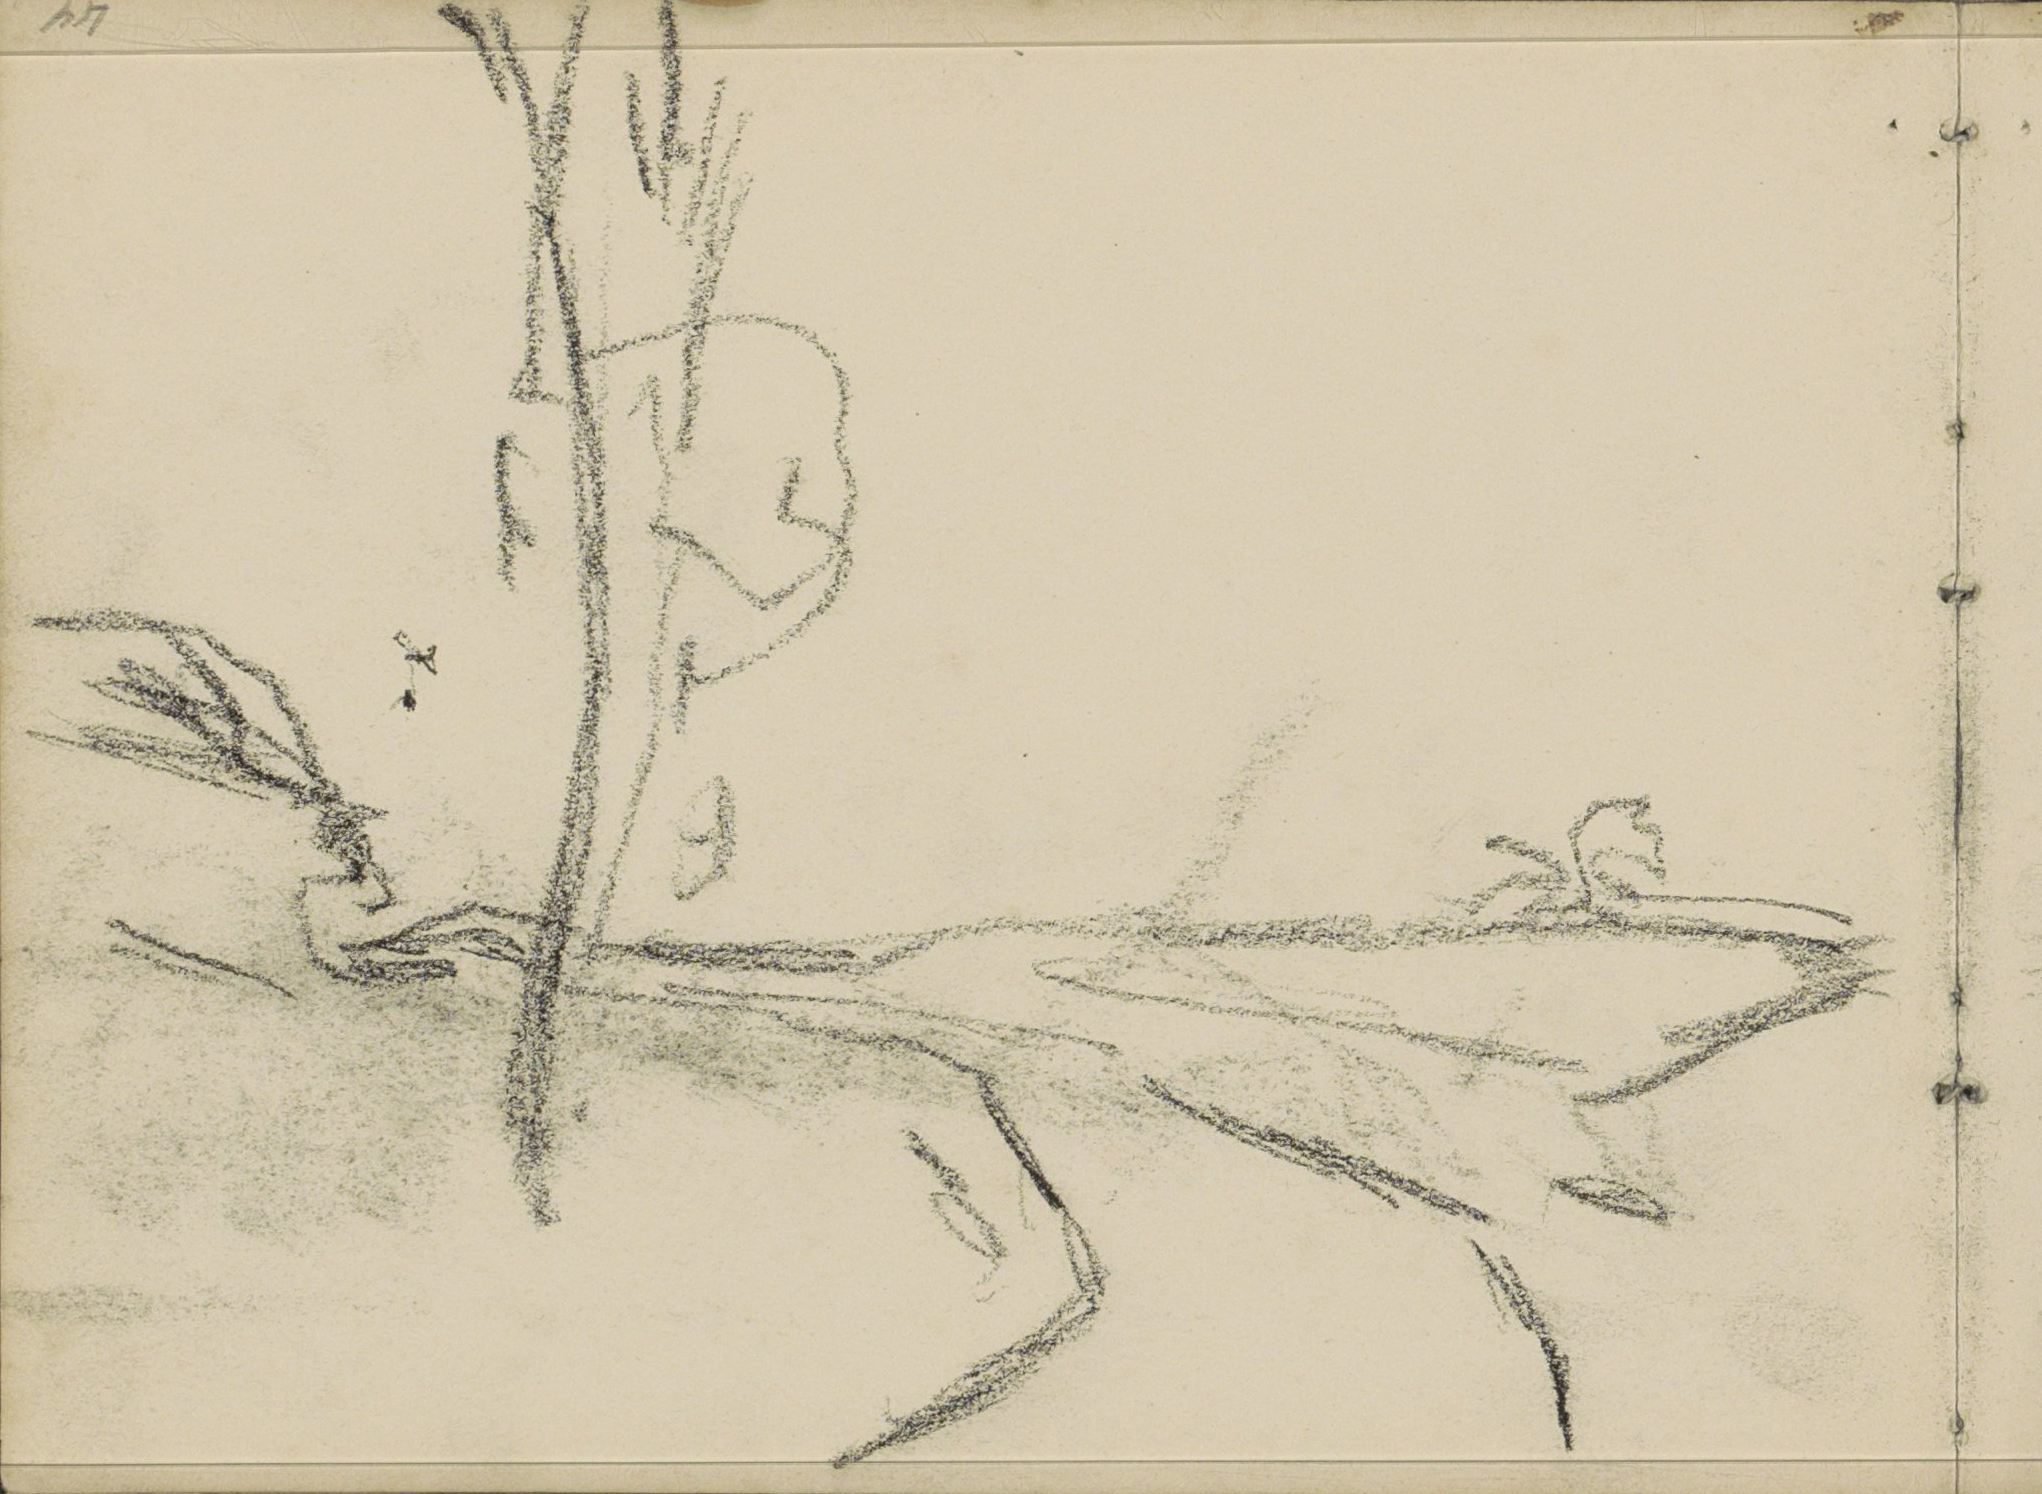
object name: sketchbook leaf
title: Pad in een landschap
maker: hermannus adrianus van oosterzee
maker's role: draughtsman, painter, print maker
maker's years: 1863-1933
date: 1893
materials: charcoal, paper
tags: landscapes, fence, wall, paling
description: Blad 3 verso uit een schetsboek met 23 bladen.